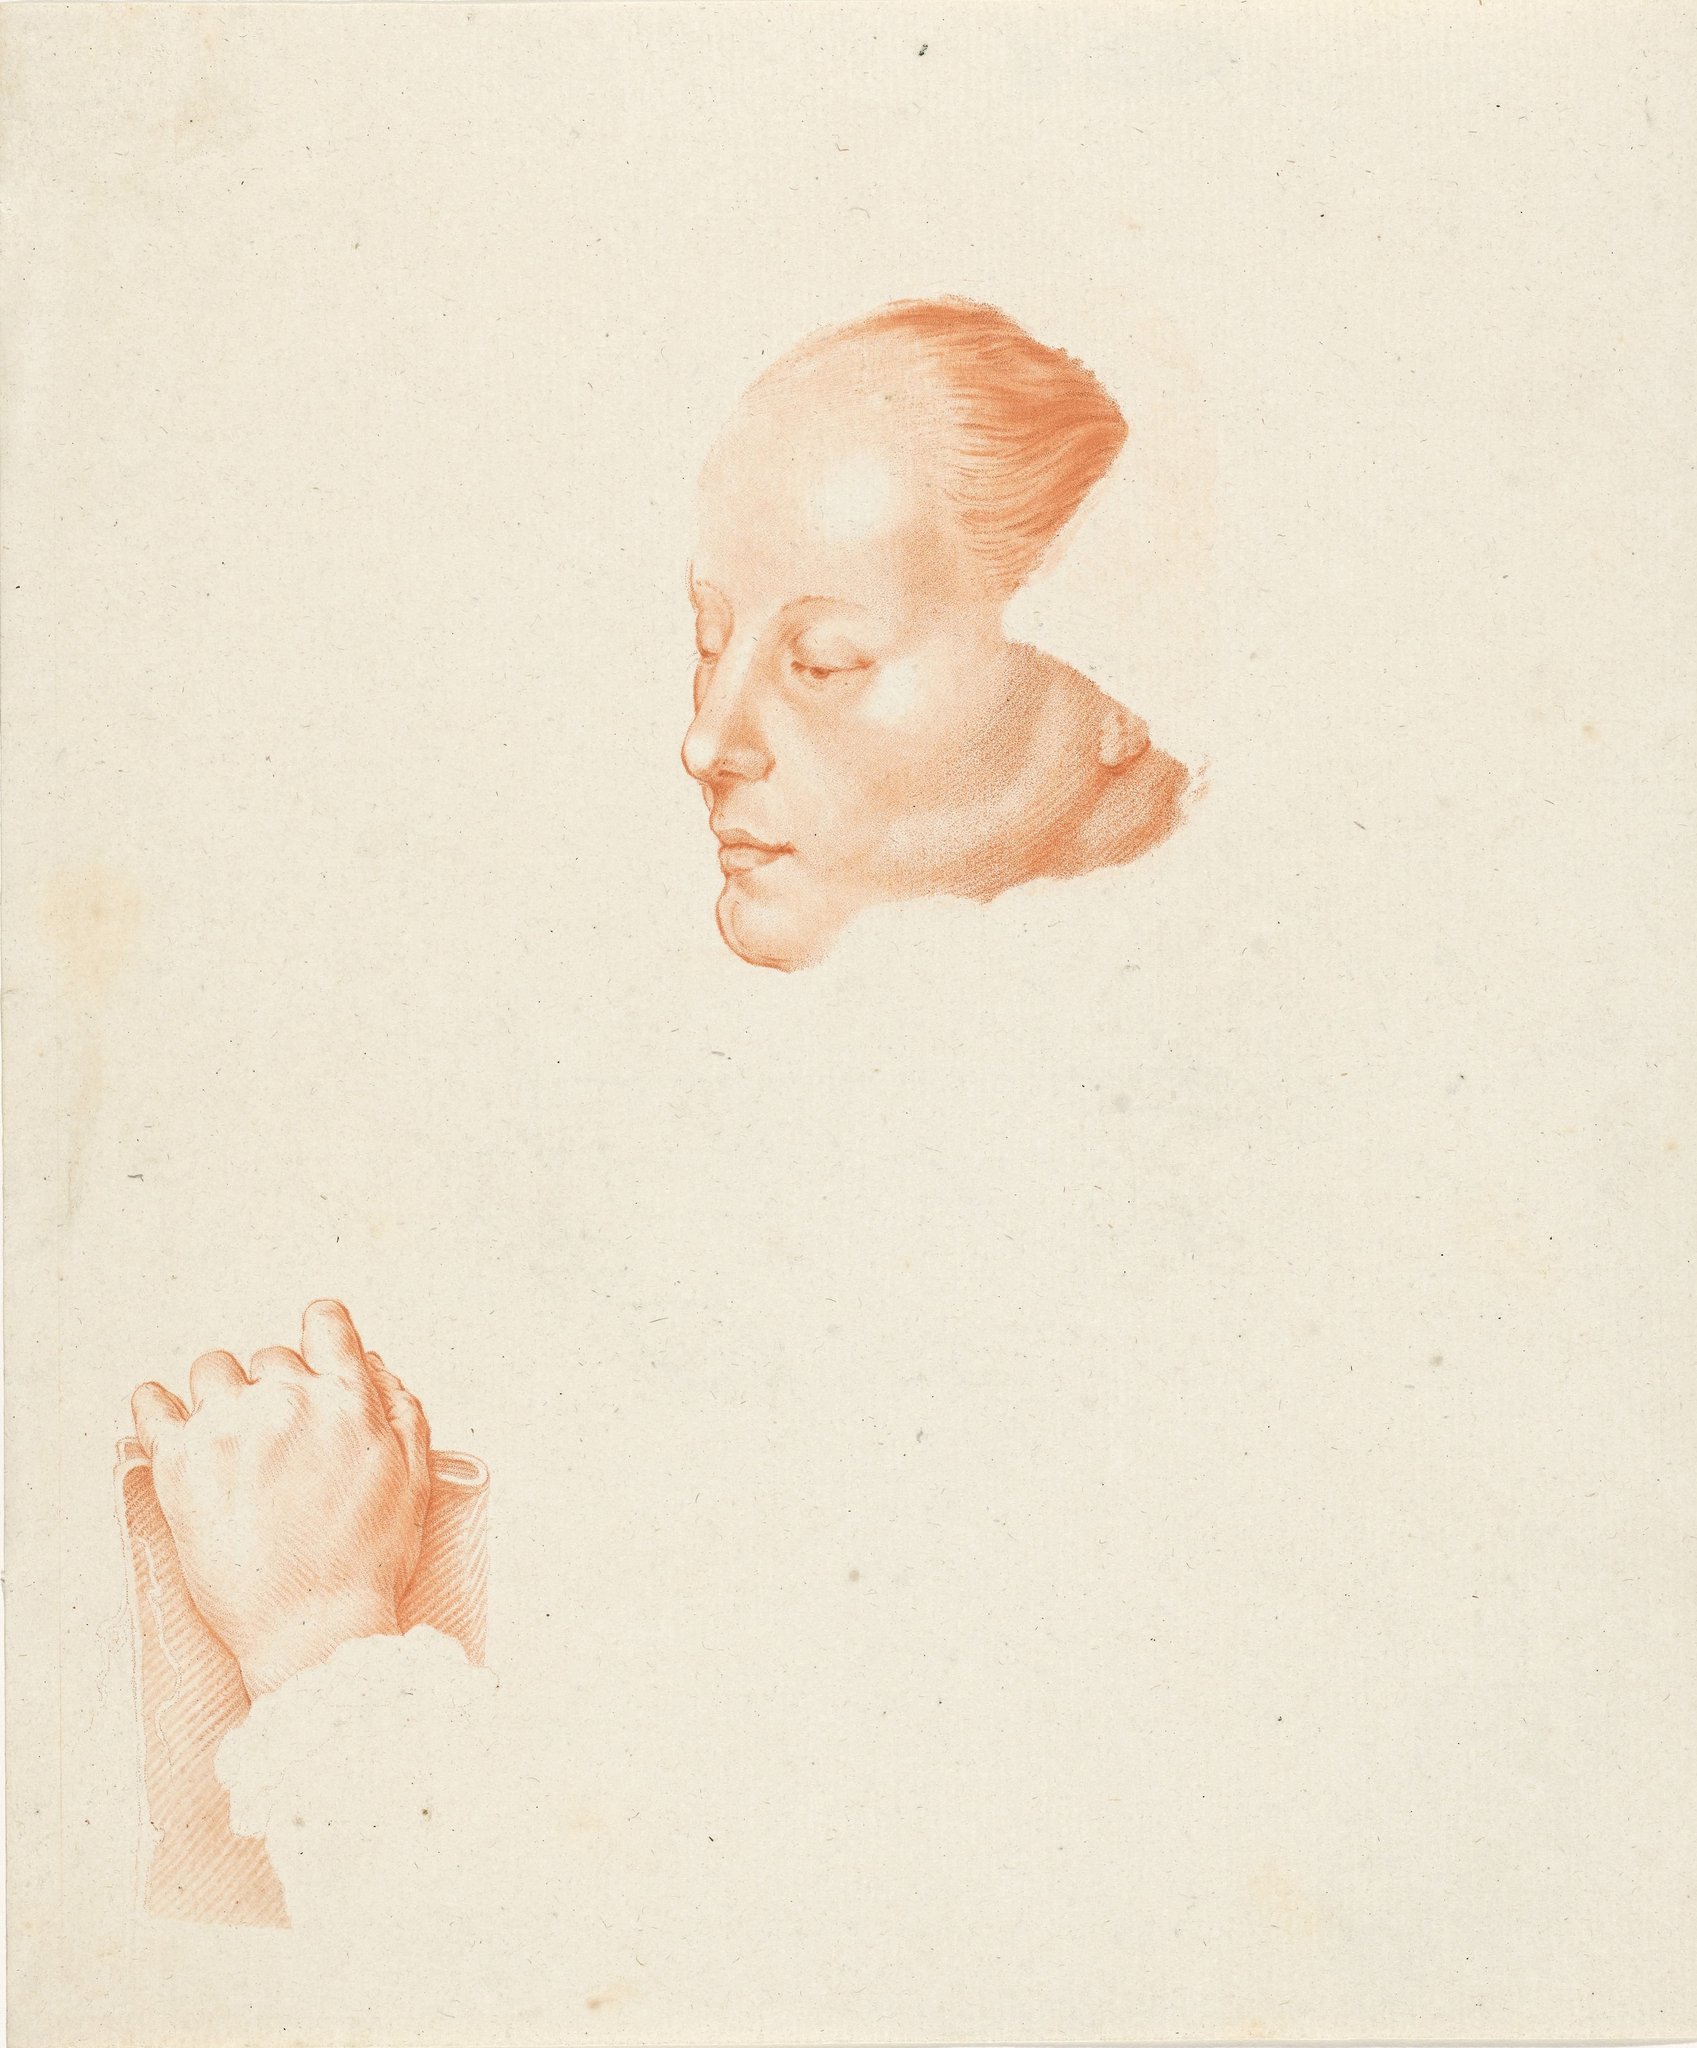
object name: print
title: Portret van Maria Tesselschade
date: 1770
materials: paper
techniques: printing, printmaking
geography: amsterdam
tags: maria tesselschade roemers visscher, adult woman, book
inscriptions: collector's mark: Lugt 2760, collector's mark: Lugt 2725, collector's mark: Lugt 2228, inscription: ‘Geoffreerd aan mijnen waarde vriend de heer Hemsterhuis P v Amstel 3 proef af / Hendr Goltzius del 1612’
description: Naar een tekening van Hendrick Goltzius in het Amsterdam Museum. Vanaf de achttiende eeuw werd de geportretteerde, onder andere door Cornelis Ploos van Amstel, regelmatig aangeduid als zijnde Maria Tesselschade Roemer Visscher, maar dat is onjuist gebleken.